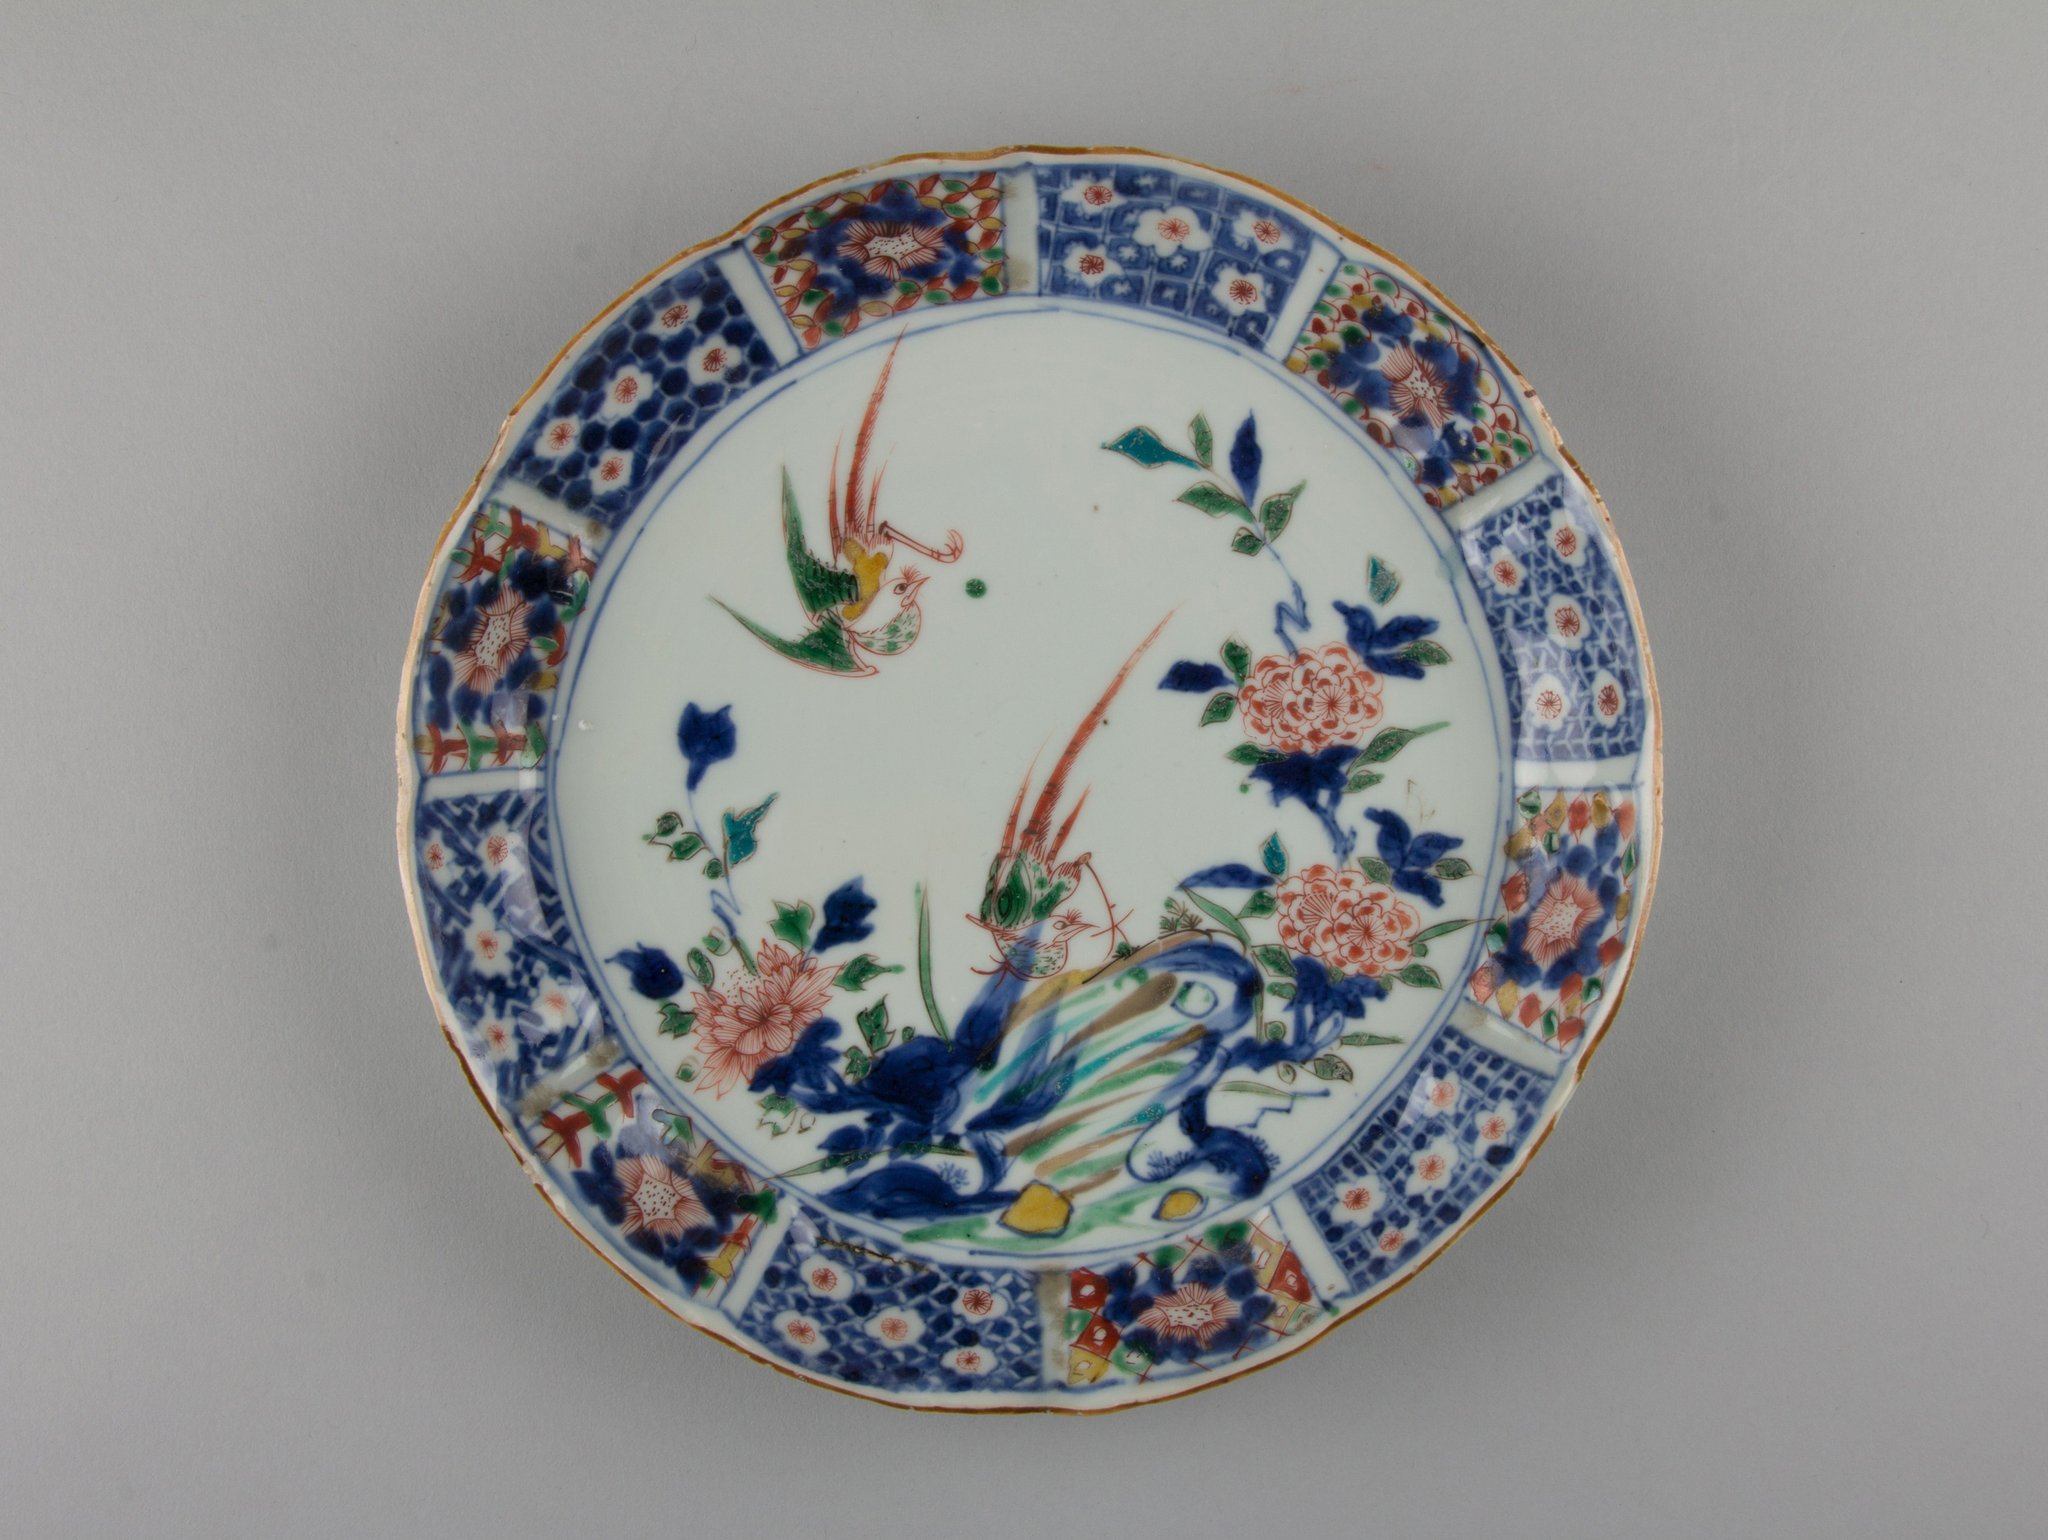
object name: dish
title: Dish with birds and flowers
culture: chinese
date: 1601-1700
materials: cobalt, enamel, porcelain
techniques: overglaze, painting, polychrome, underglaze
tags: birds,flowers